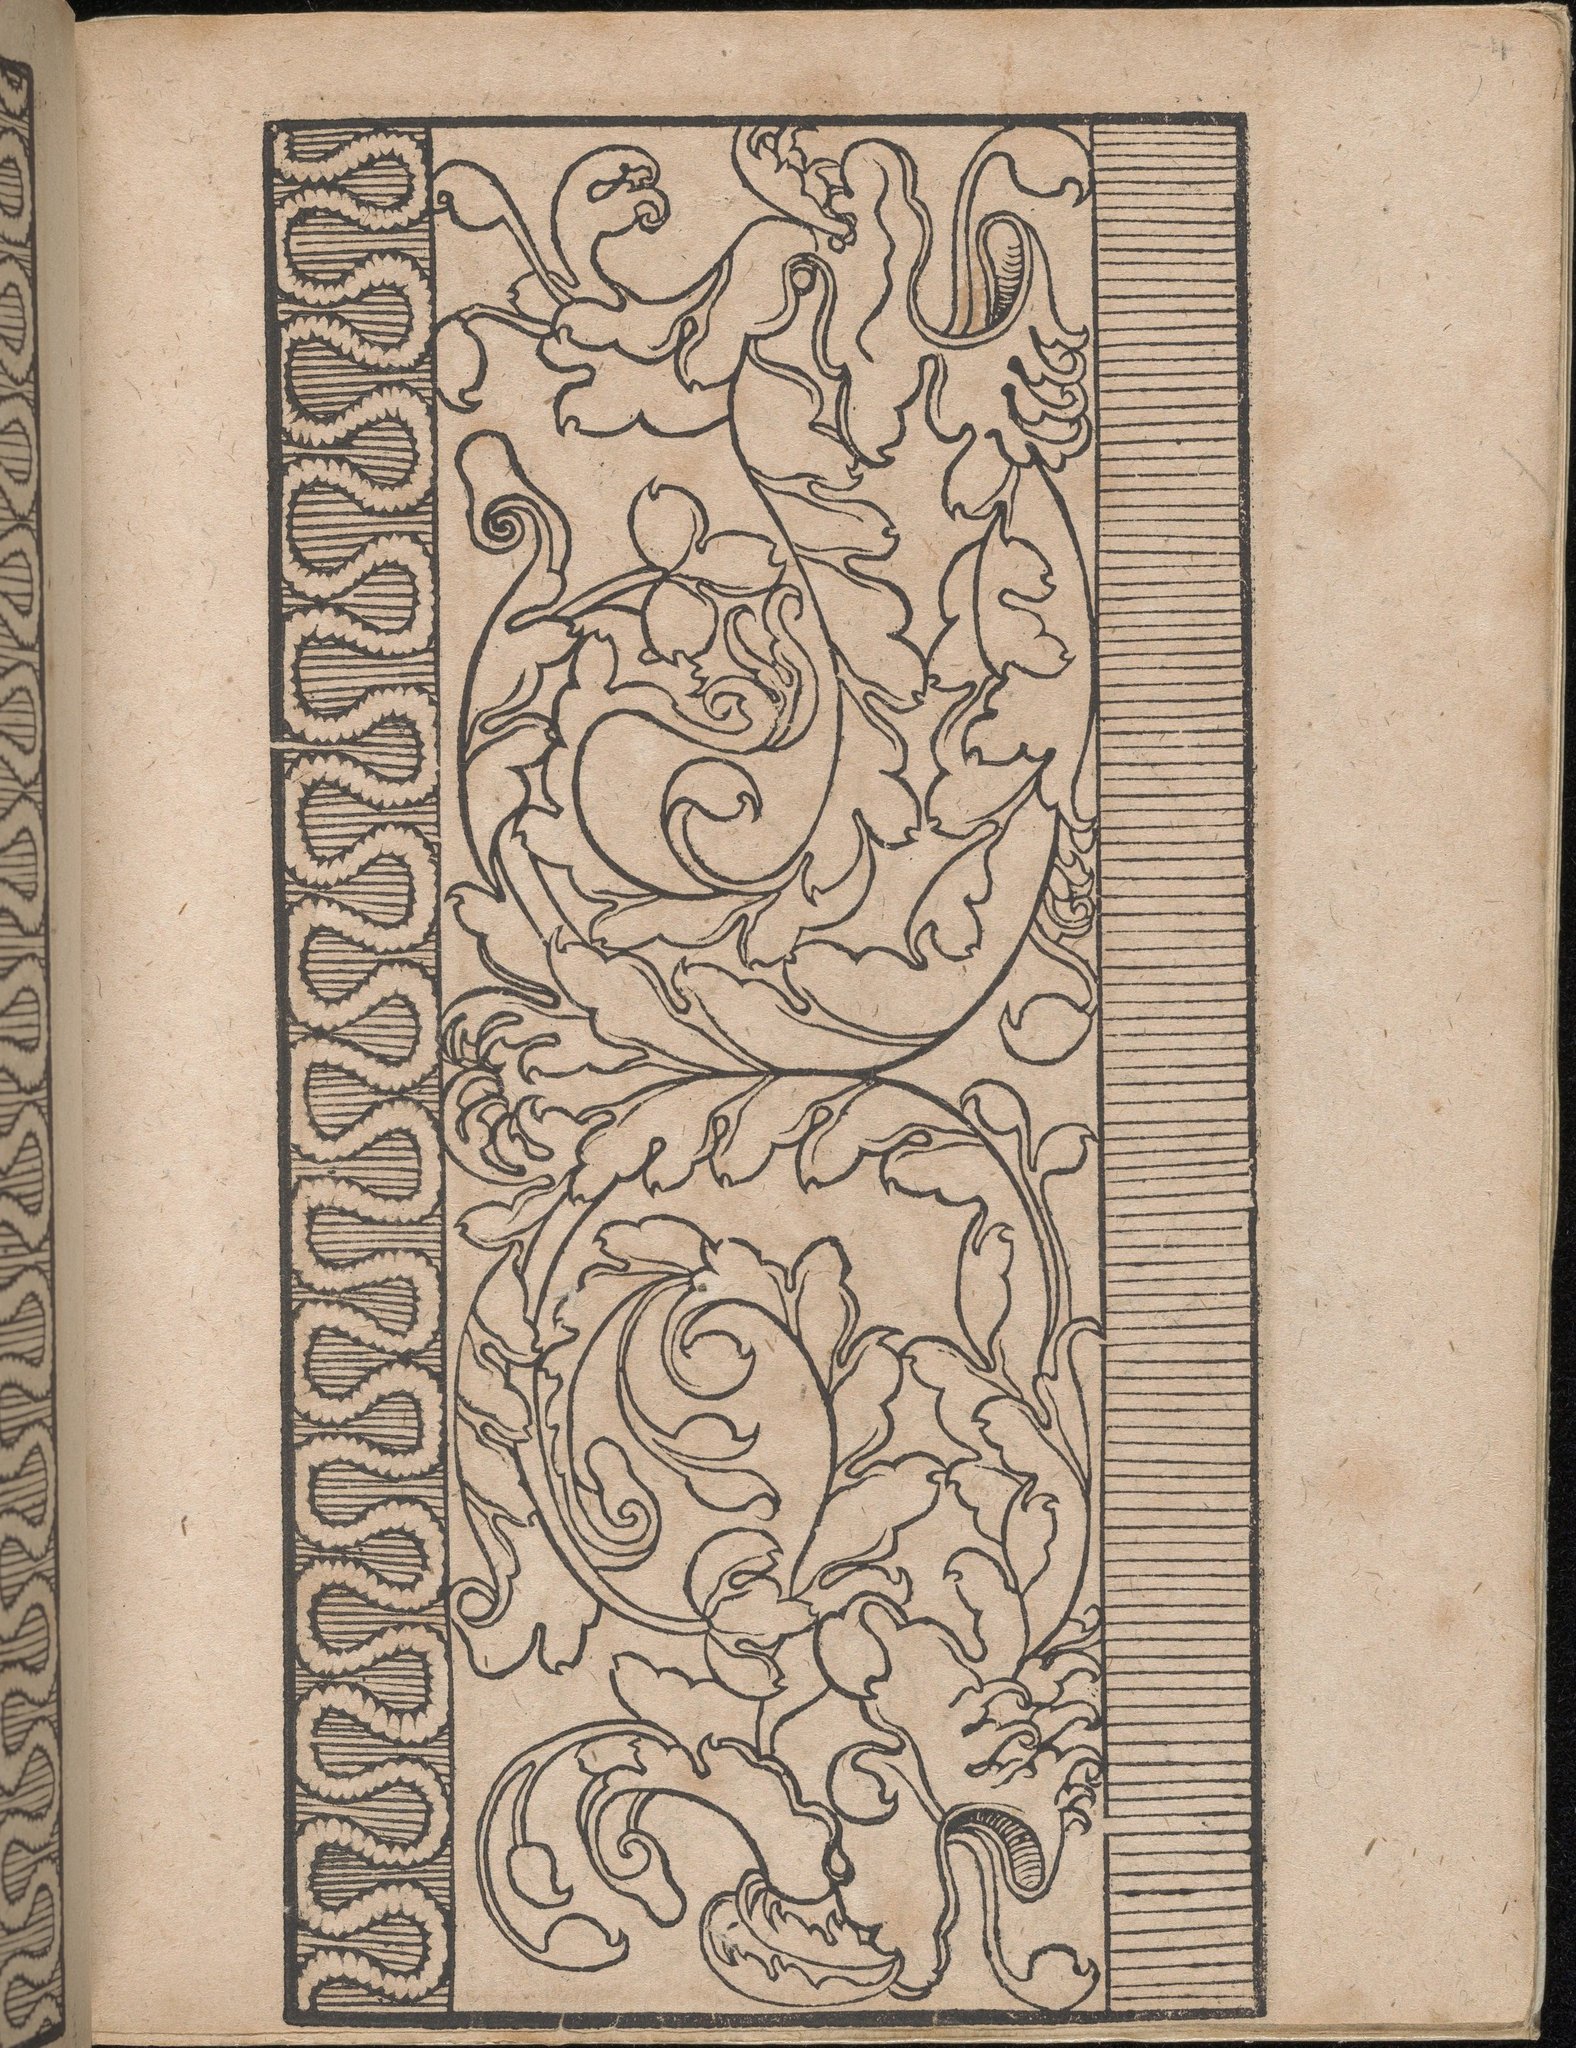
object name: book print ornament architecture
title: Ein new Modelbuch..., page 2 (verso)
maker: johann schönsperger the younger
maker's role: publisher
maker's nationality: german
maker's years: 1490-1550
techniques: woodcut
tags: ornament,vines